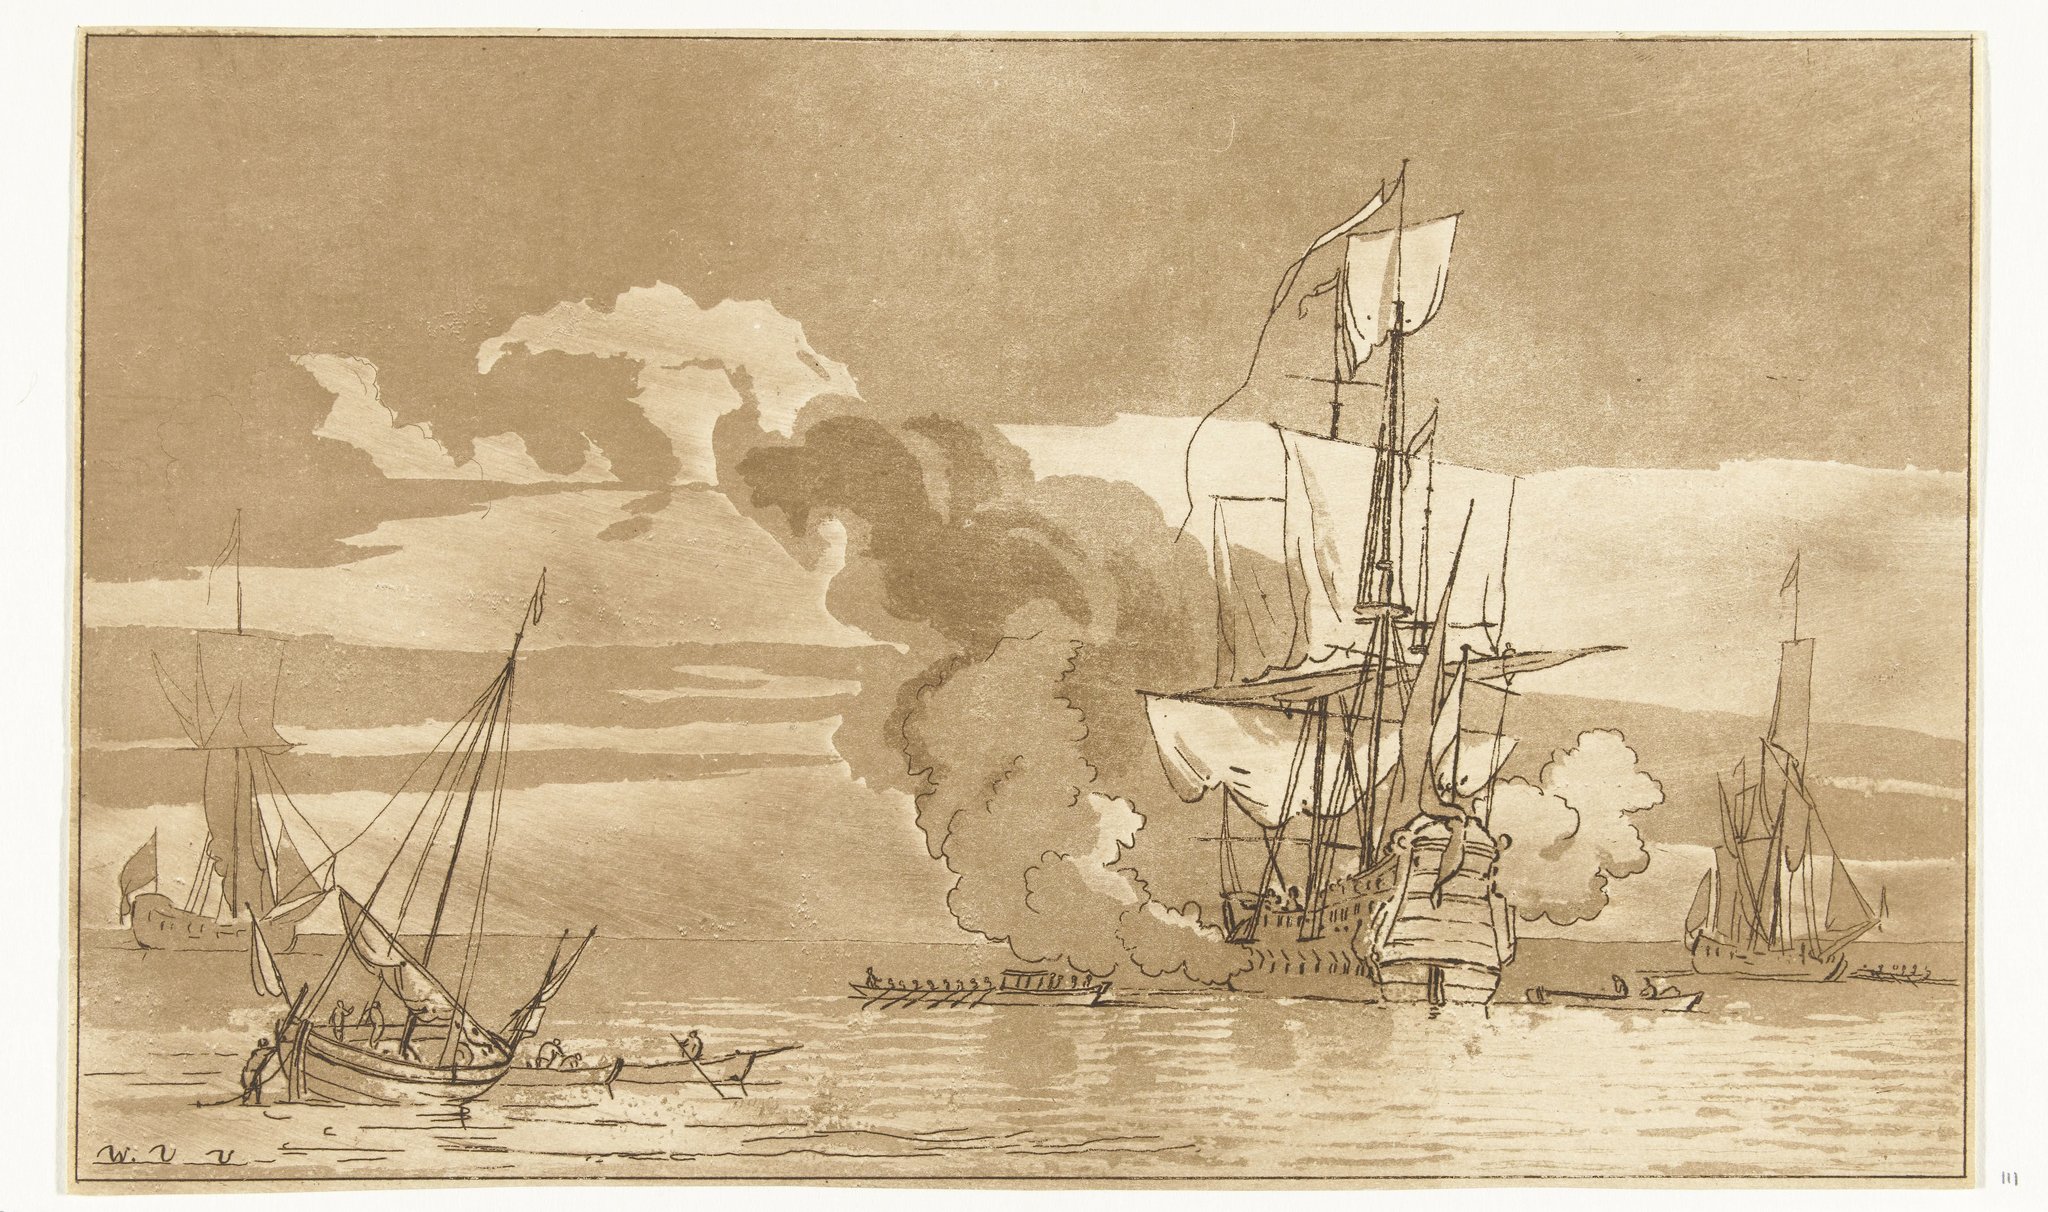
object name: print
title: Zeeslag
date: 1778-1832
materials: paper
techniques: aquatint, etching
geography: netherlands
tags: battle (+ sailing-ships)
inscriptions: collector's mark: Lugt 2228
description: Een oorlogsschip bij windstilte met slappe zeilen lost een kanonschot. Aan weerszijden twee sloepen, in de verte twee kleinere schepen. Een ander schip wordt door de bemanning aan het strand getrokken.